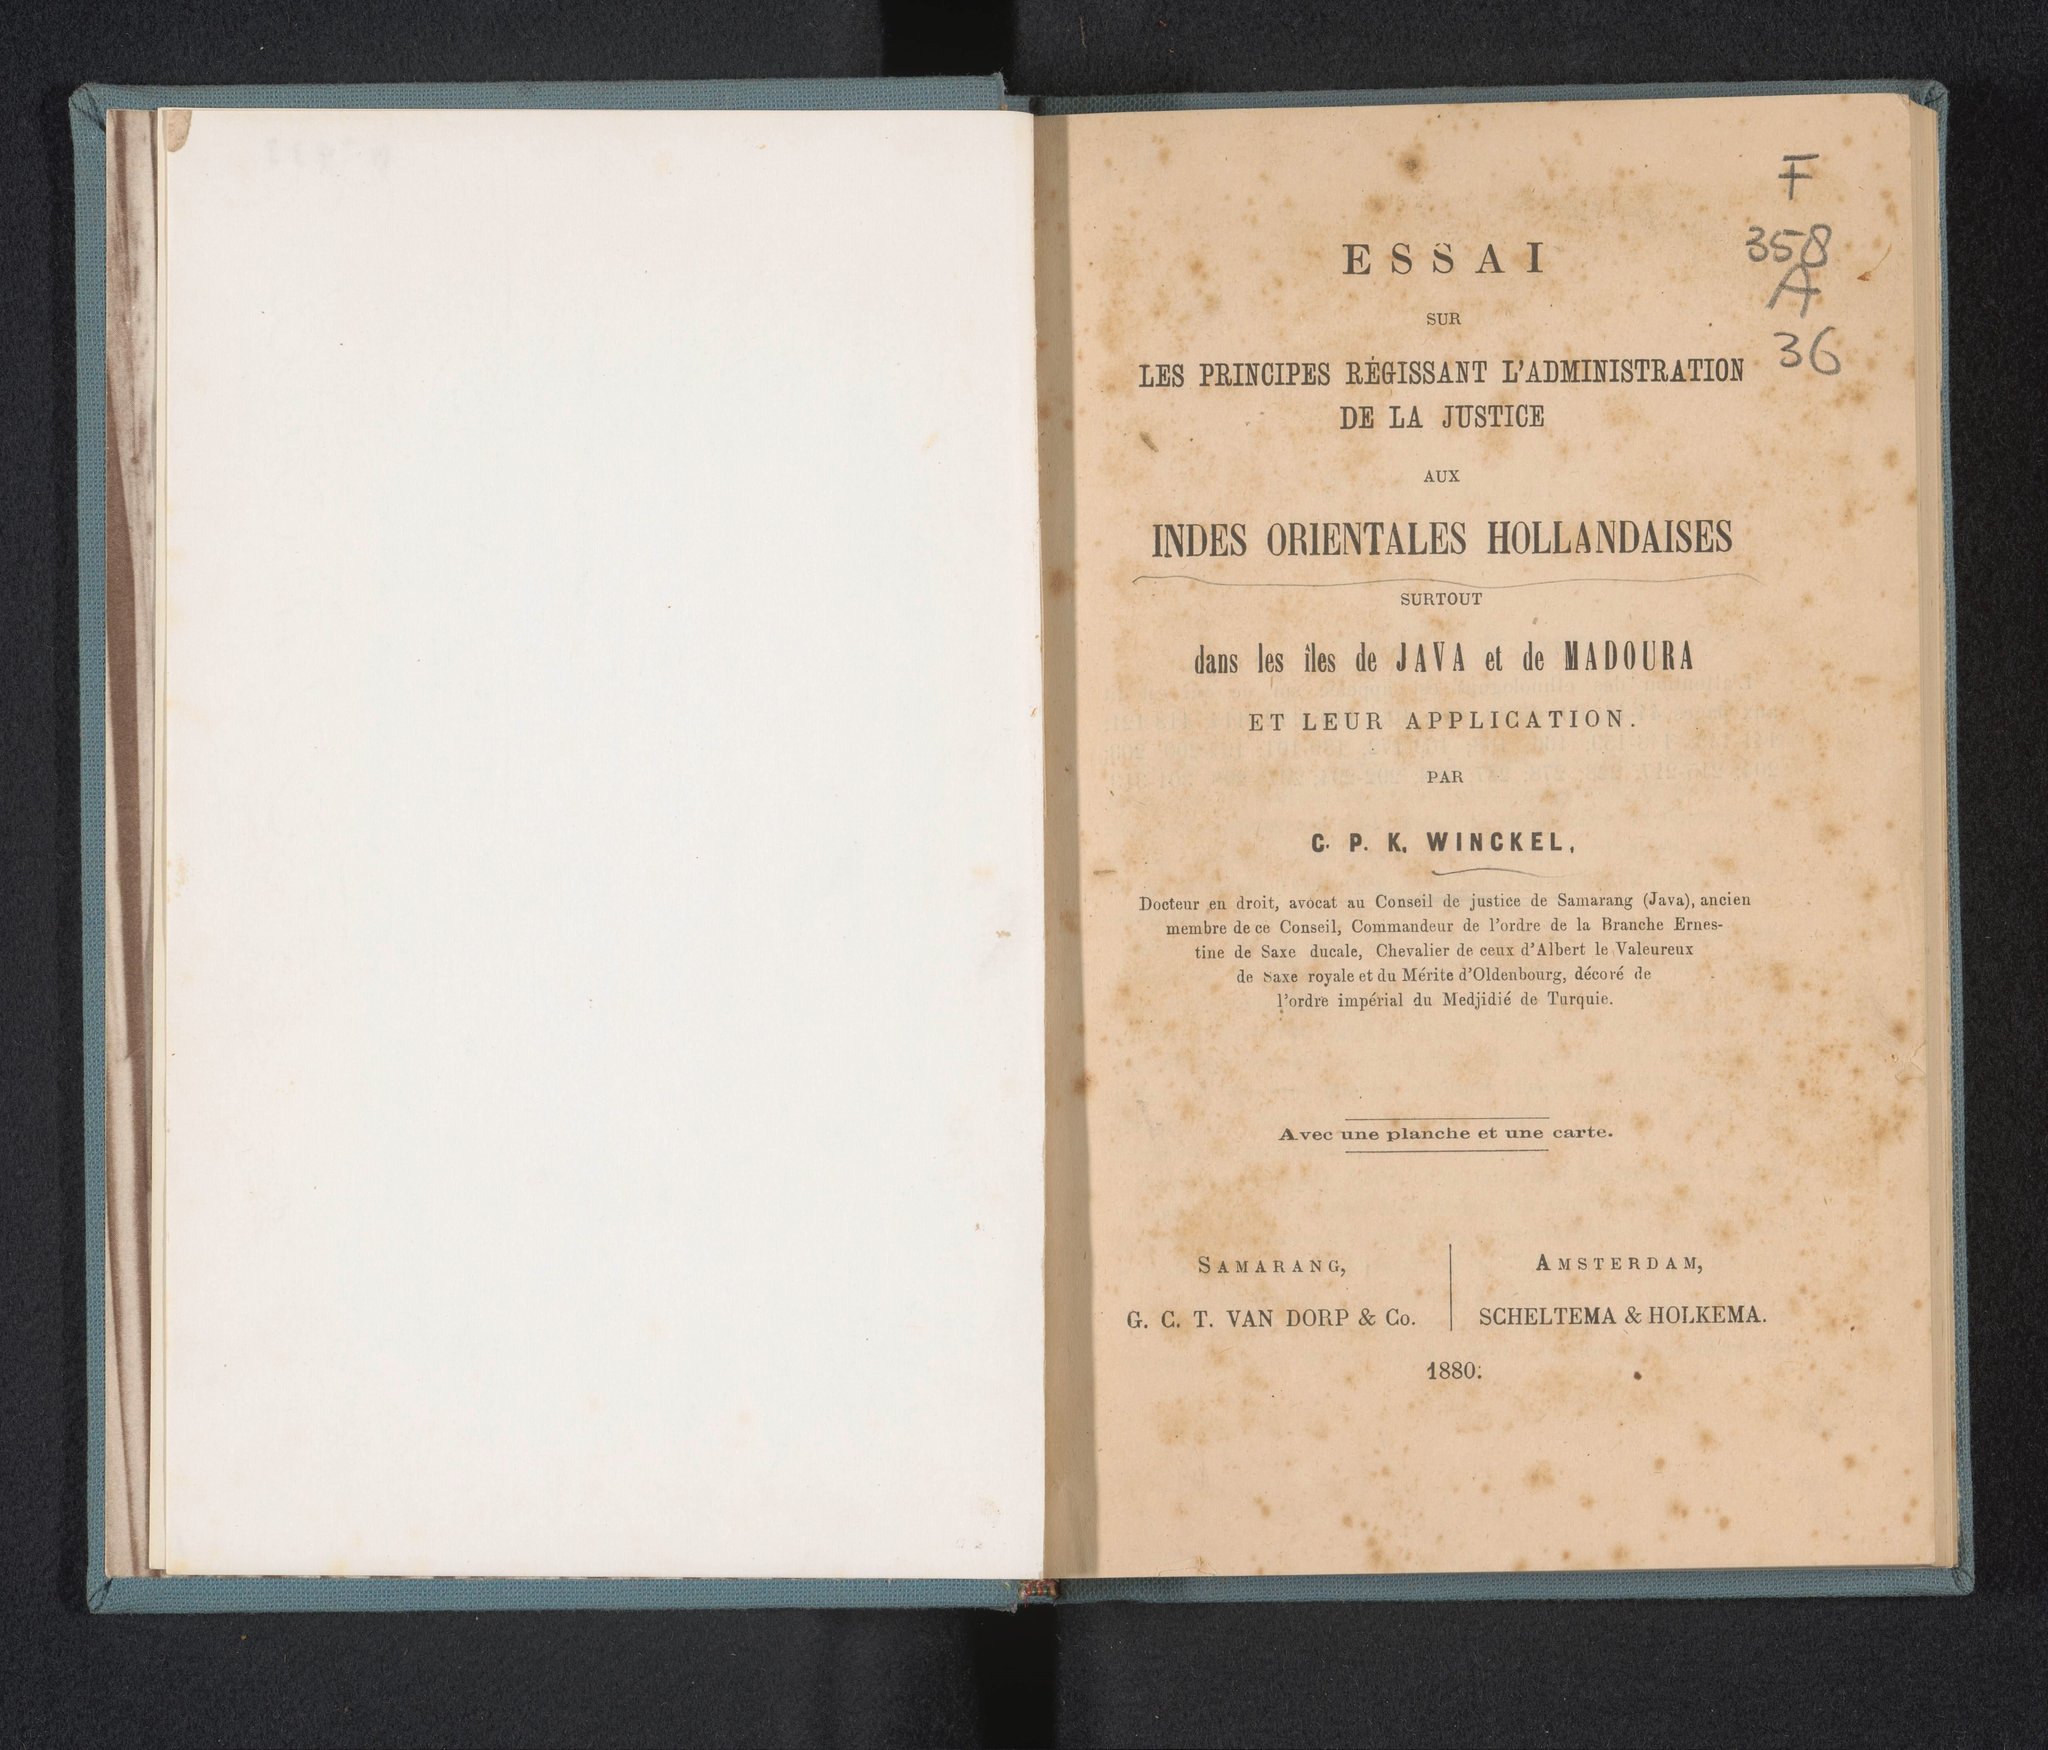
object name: book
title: Essai sur les principes régissant l'administration de la justice aux Indes Orientales hollandaises surtout dans les îles de Java et de Madoura et leur application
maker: christiaan philip karel winckel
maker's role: advocaat, procureur, rechter, schrijver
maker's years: 1842-1884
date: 1880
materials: linen, paper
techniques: printing, rotogravure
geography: semarang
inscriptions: annotation: ‘N 433’, date: ‘Aug 1992’